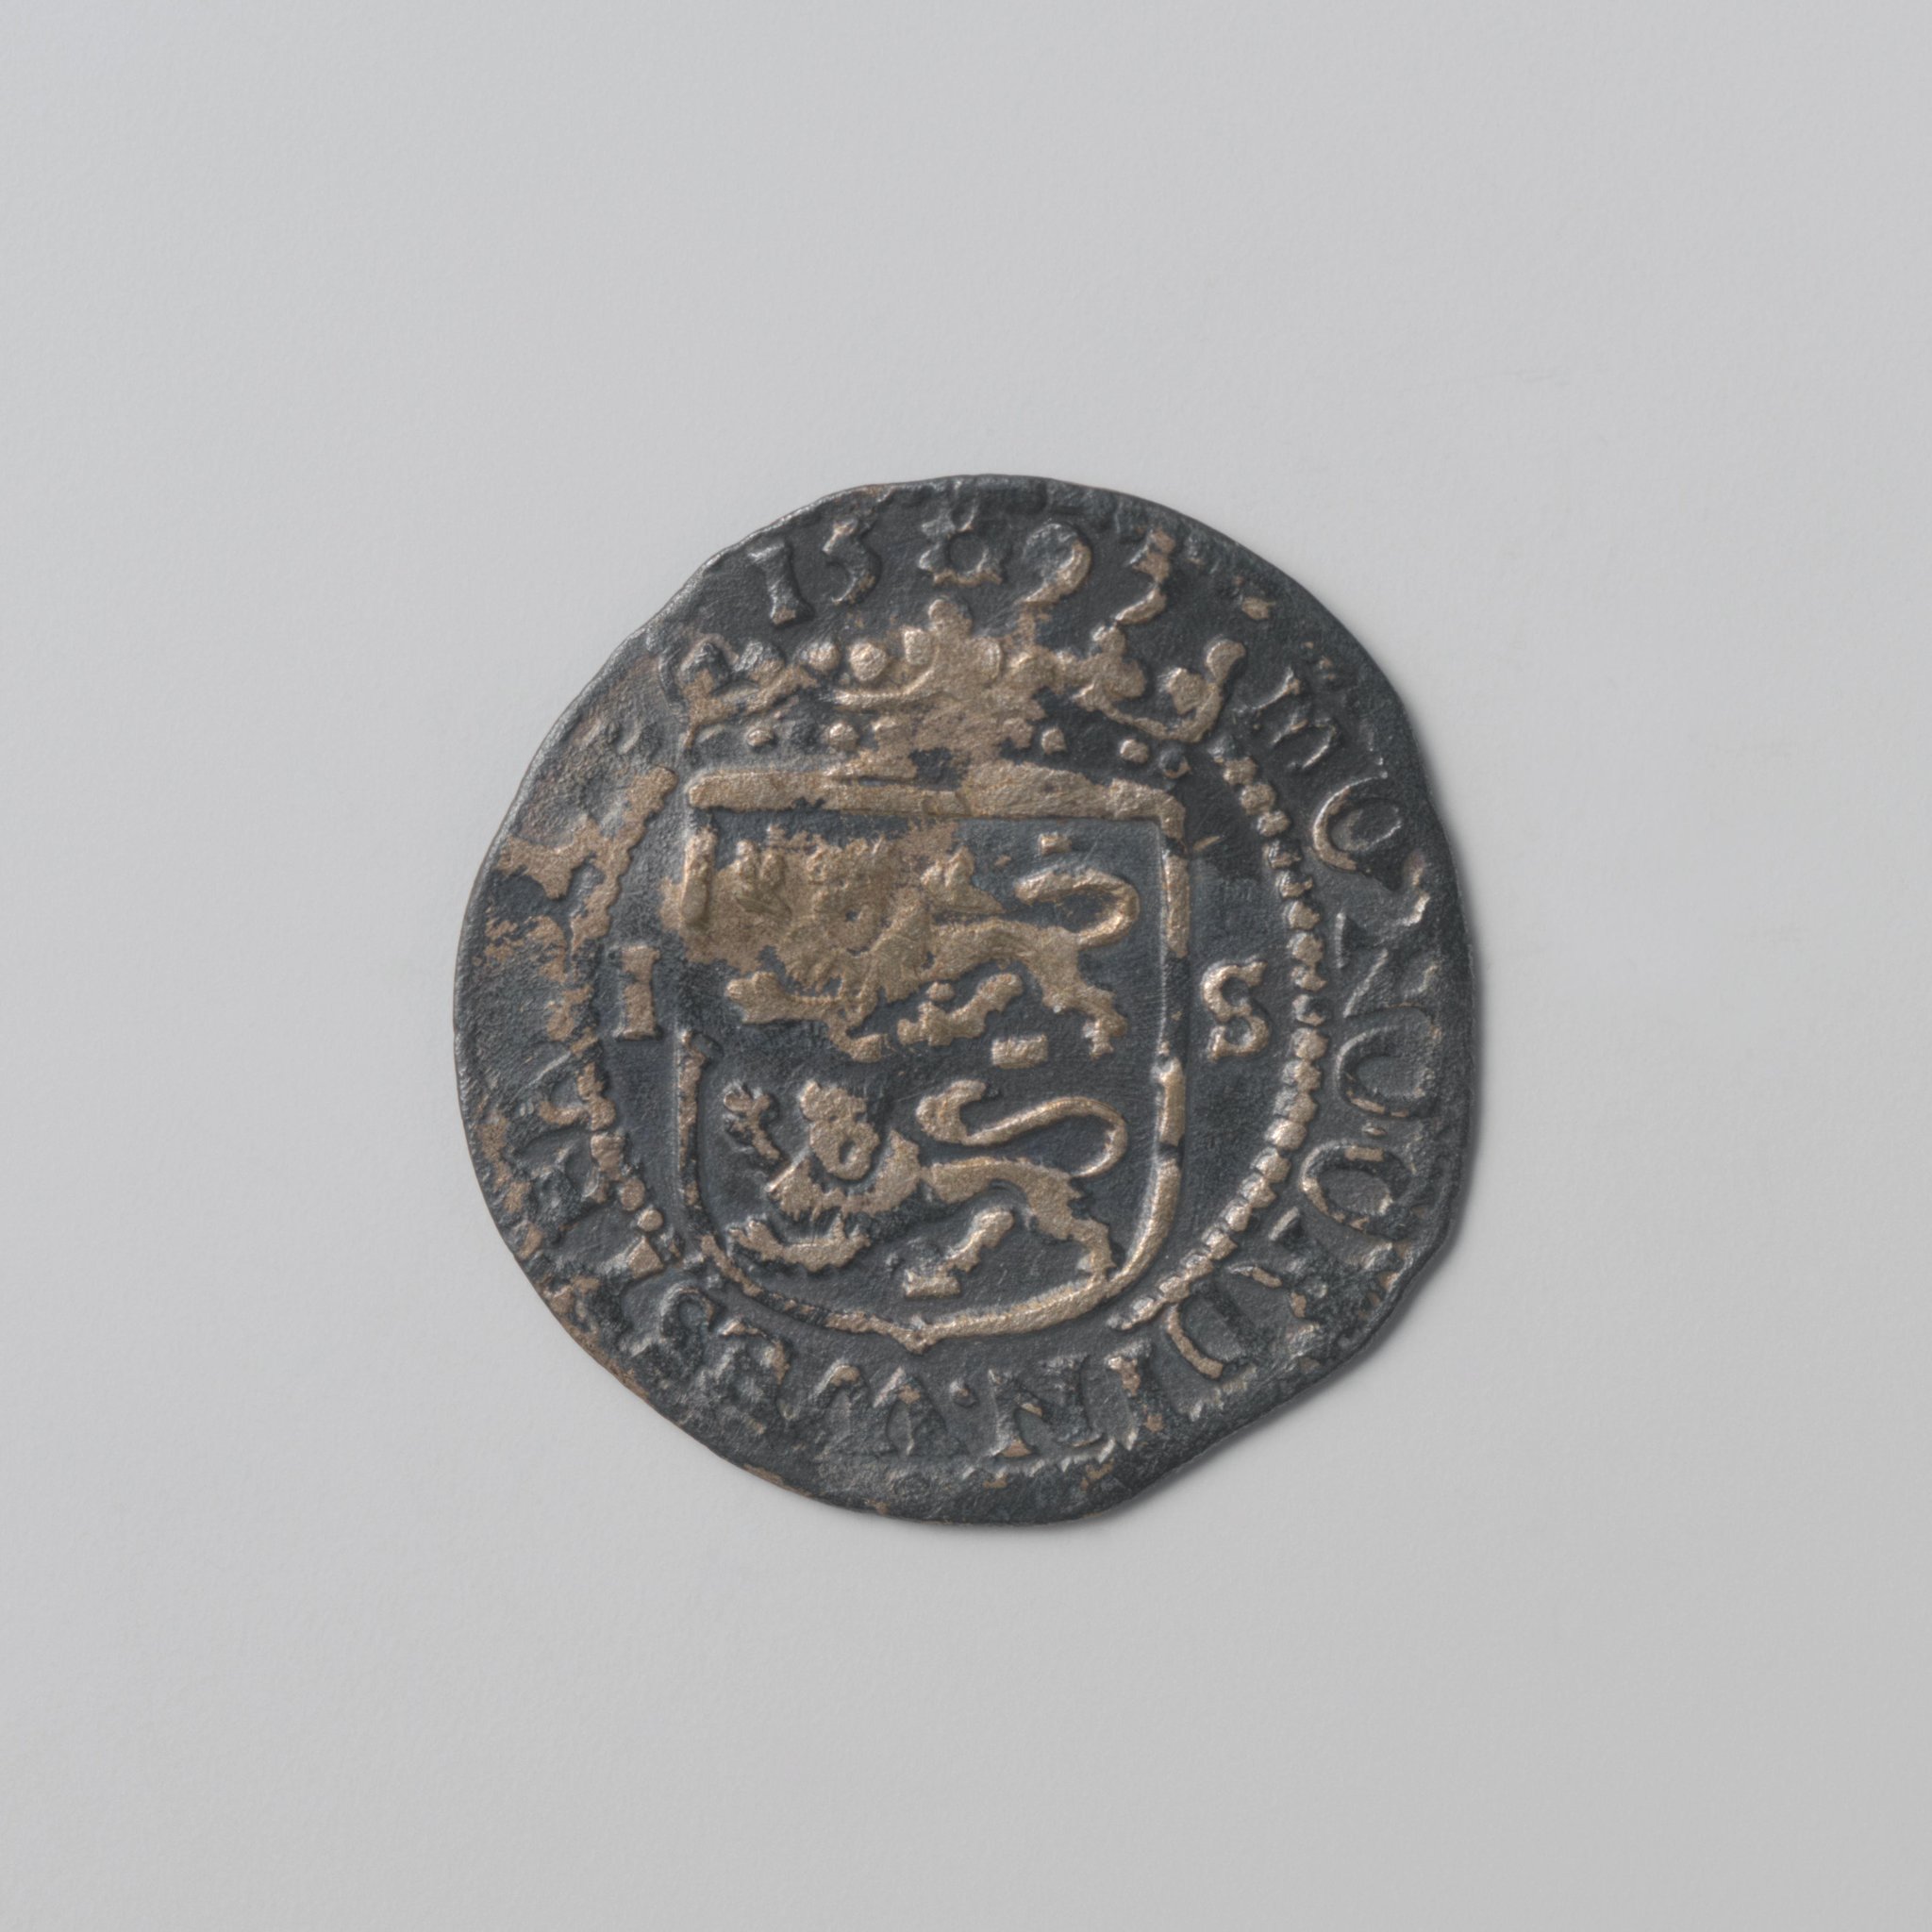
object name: coin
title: West-Friesland, stuiver, 1597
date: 1597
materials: silver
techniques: striking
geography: west frisia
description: Zilveren munt. Voorzijde: tussen waarde-aanduiding gekroond wapenschild van West-Friesland. Jaartal boven kroon. Keerzijde: op vierpas lang versierd kruis, in het hart letters WF.